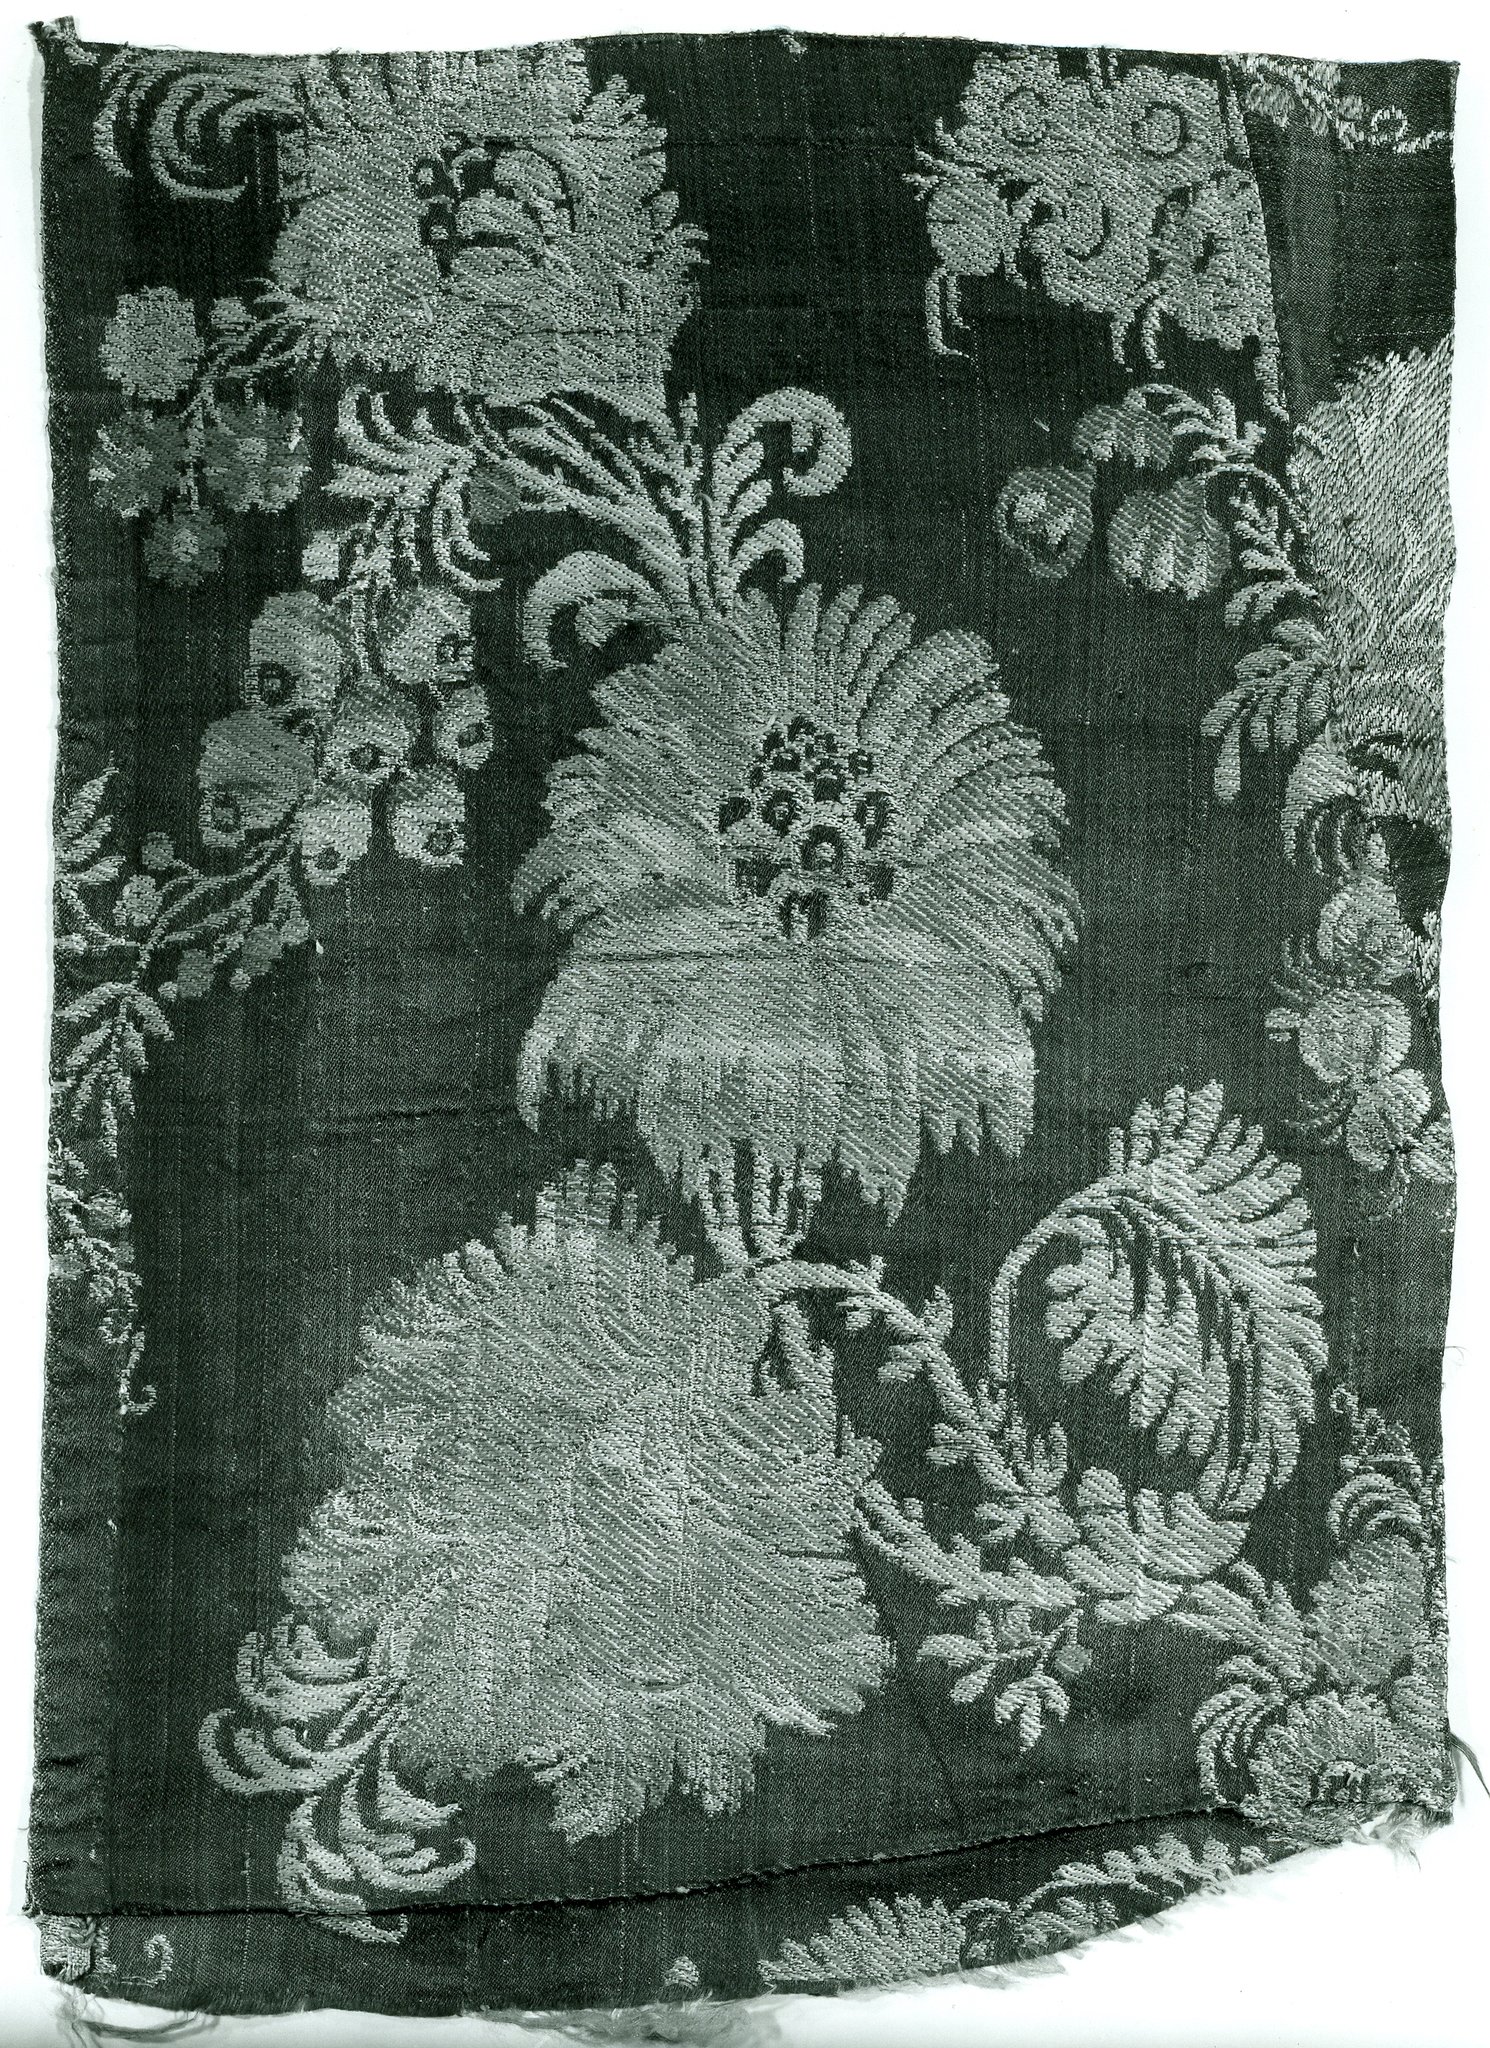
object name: textile cover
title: Cover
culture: french or italian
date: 1701-1800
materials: cotton, metal, silk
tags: flowers